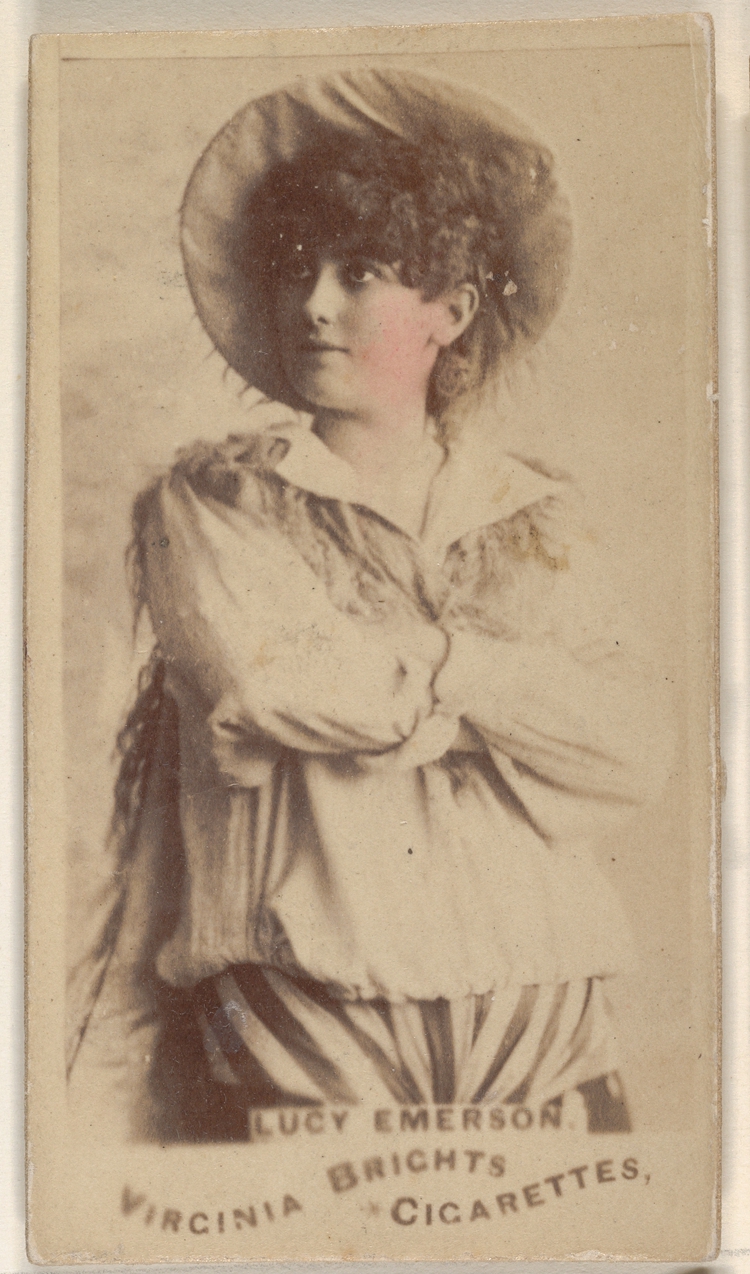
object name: photograph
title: Lucy Emerson, from the Actors and Actresses series (N45, Type 1) for Virginia Brights Cigarettes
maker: allen & ginter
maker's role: publisher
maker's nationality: american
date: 1888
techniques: albumen silver print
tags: portraits,women,actresses